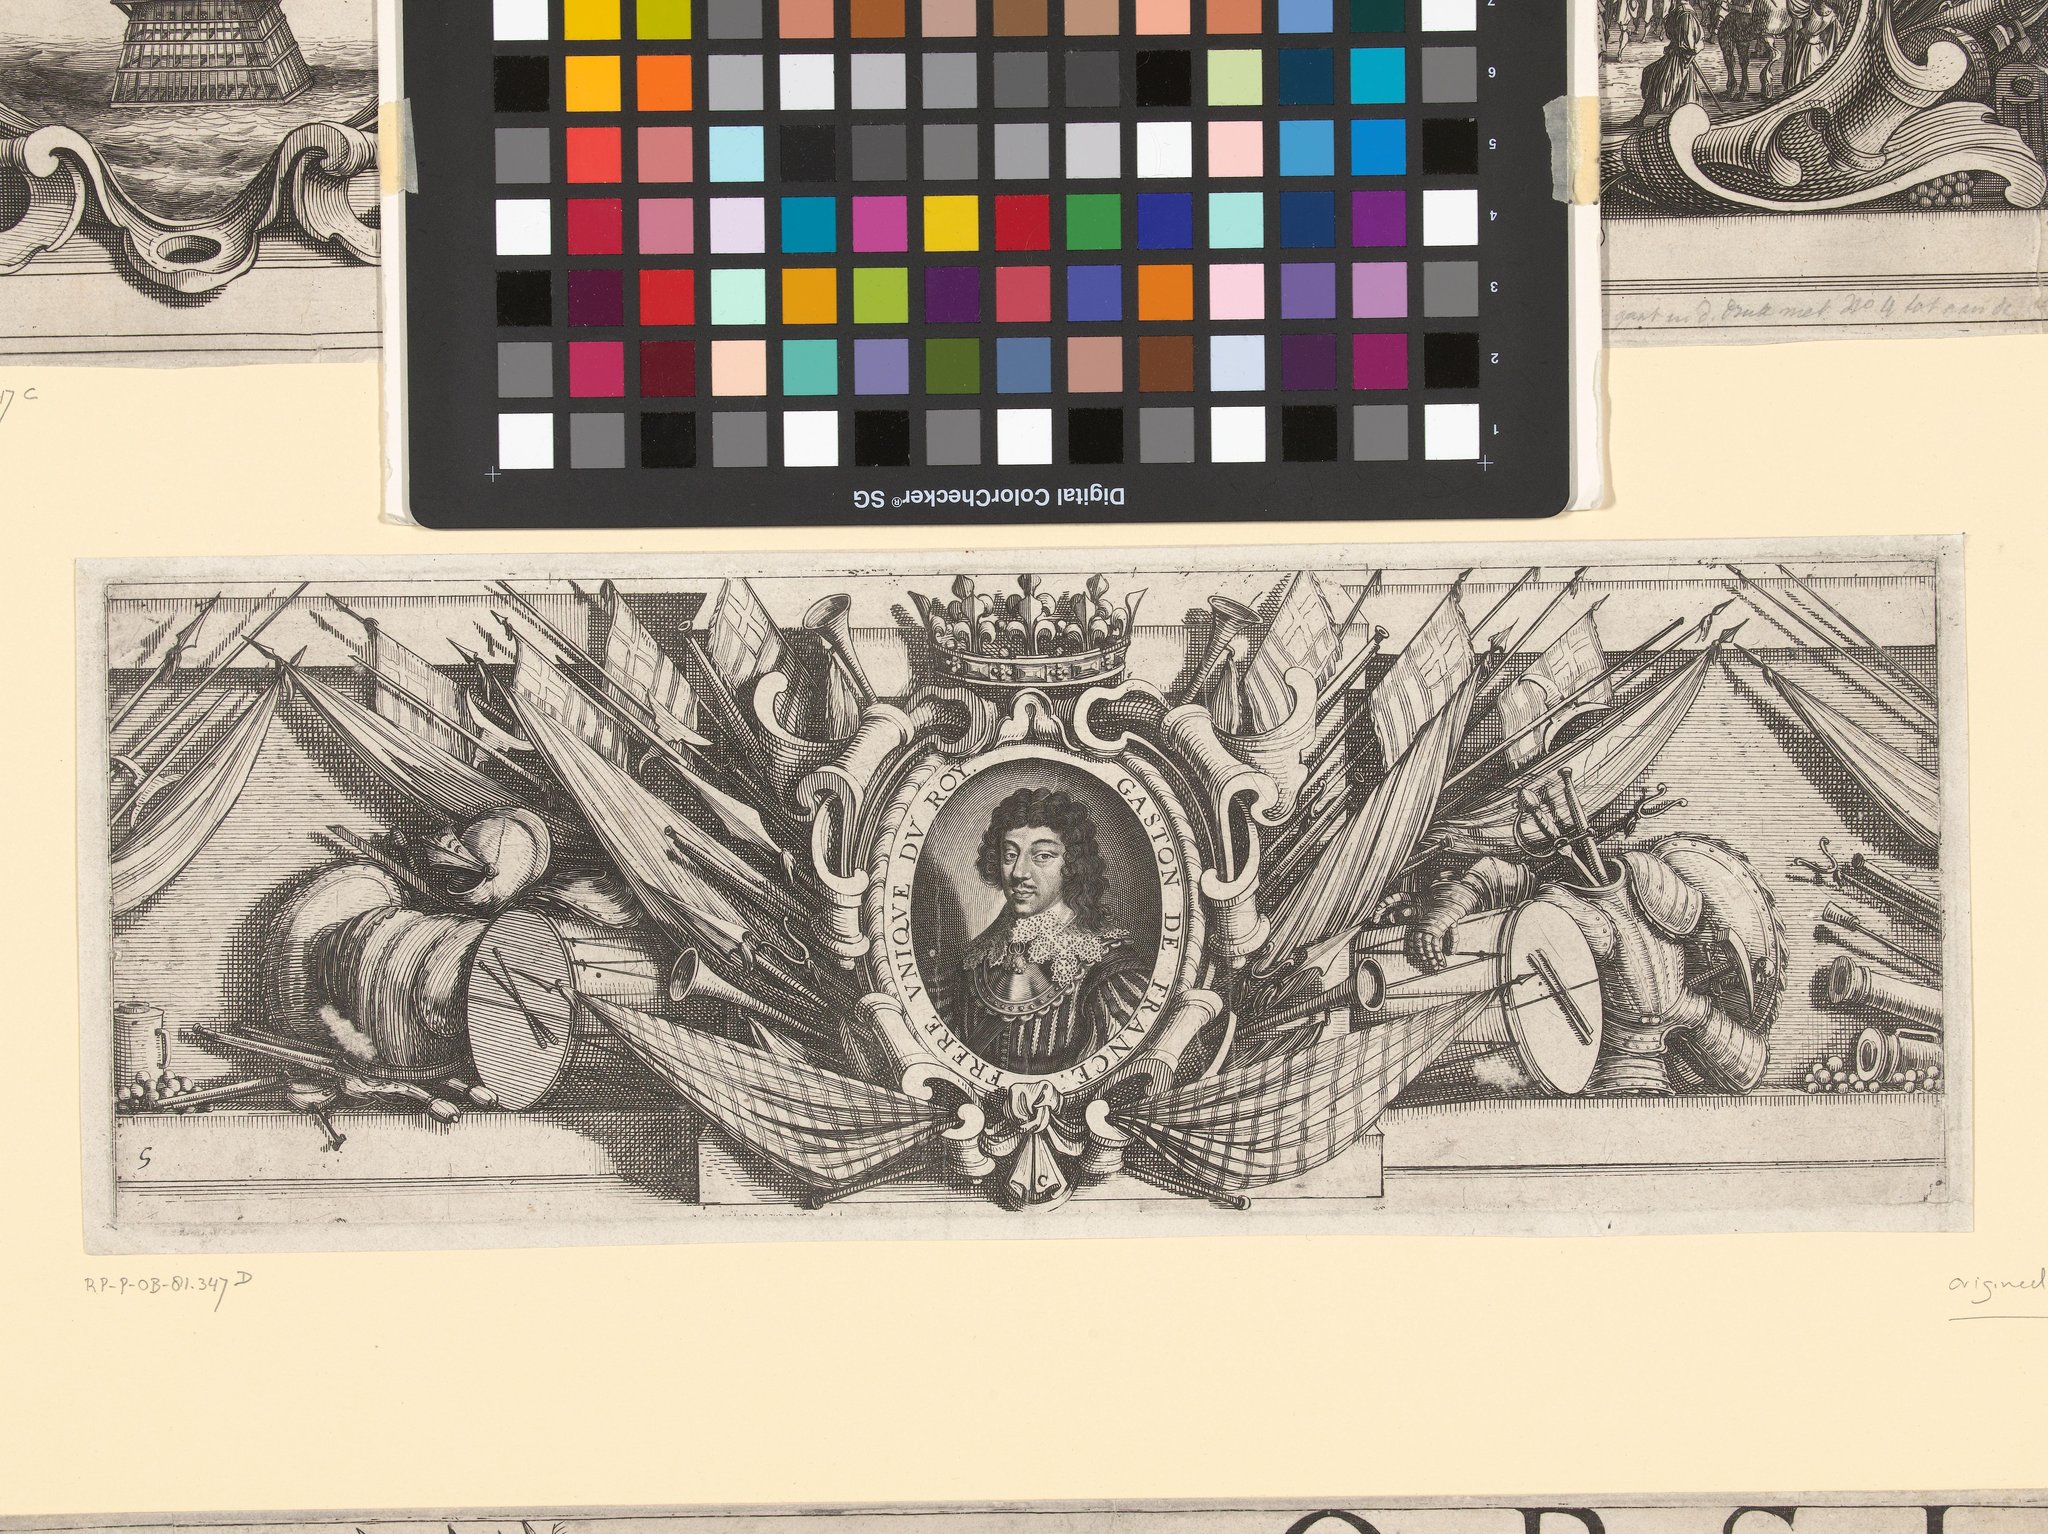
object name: print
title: Beleg van La Rochelle, september 1627-oktober 1628 (randwerk, deel middenonder)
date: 1628-1631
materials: paper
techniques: engraving, etching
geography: france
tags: gaston jean-baptiste hertog van orléans, ornament ~ cartouche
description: Grote prent van het beleg van het hugenotenbolwerk La Rochelle in de jaren 1627 en 1628, dat werd uitgevoerd in opdracht van de Franse koning door het Franse leger onder aanvoering van kardinaal Richelieu. Randwerk, deel middenonder. Op dit blad een portret van Gaston, de broer van de koning, omringd door vaandels en wapentuig.